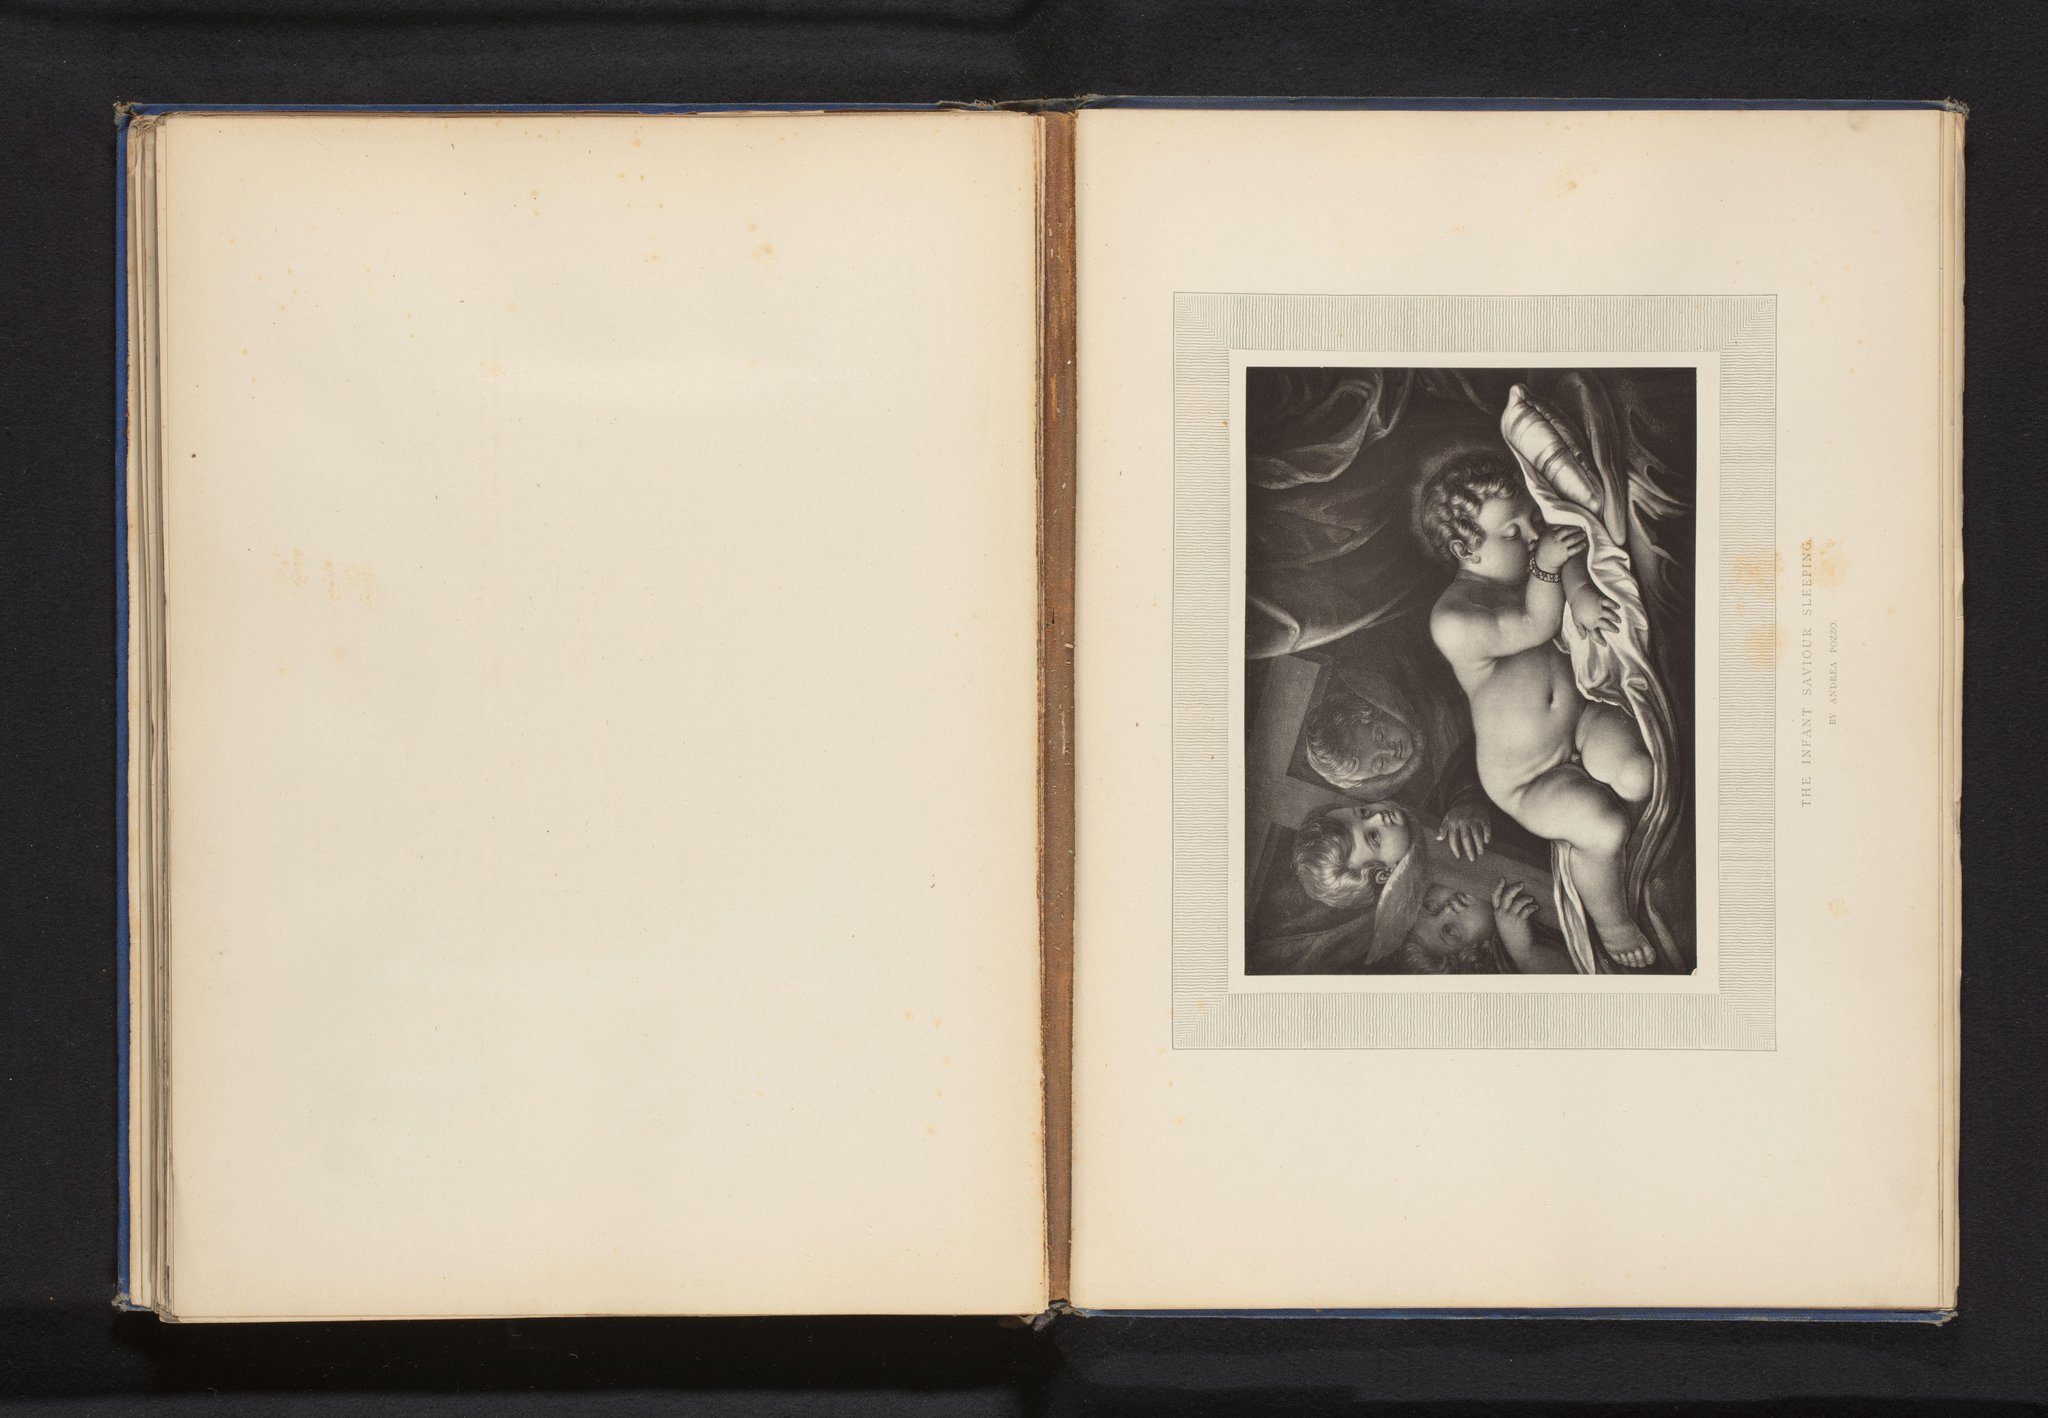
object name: page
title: Reproductie van een prent van een brieflezend meisje bij het venster naar Johannes Vermeer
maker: Anonymous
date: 1870-1875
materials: paper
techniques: woodburytype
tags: adolescent, young woman, maiden, reading, letter, envelope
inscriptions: inscription: ‘By Peter de Hooghe’